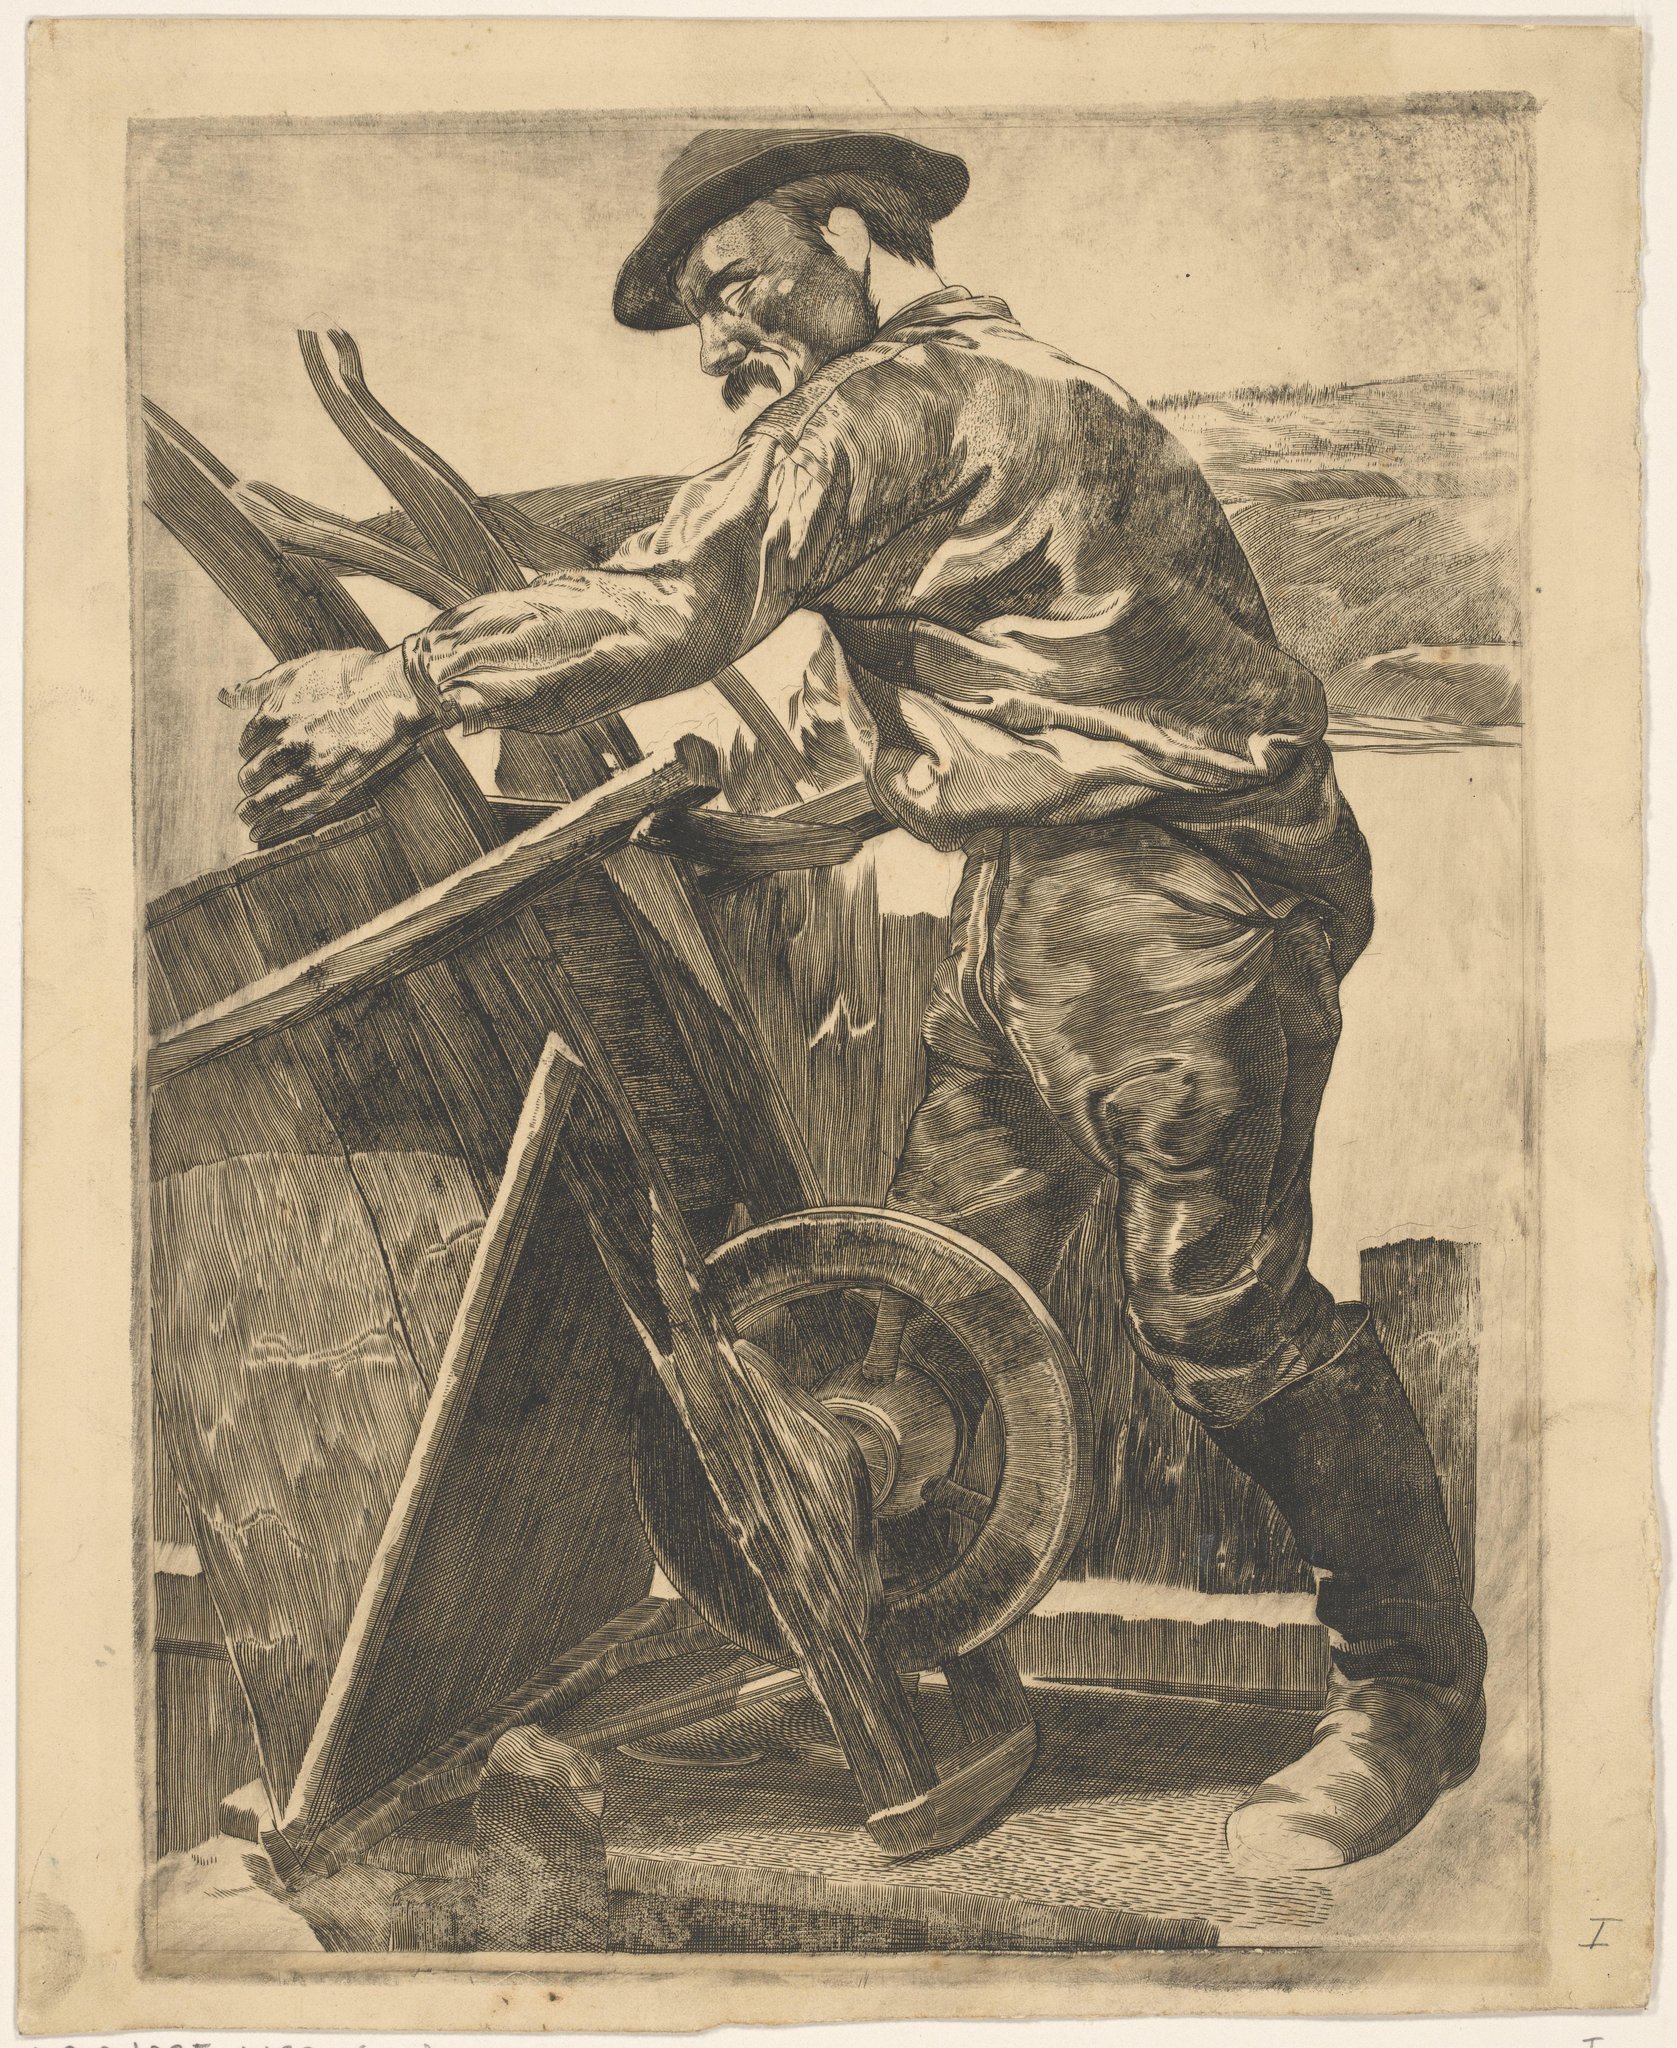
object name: print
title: Arbeider met een kruiwagen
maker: johannes josephus aarts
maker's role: draughtsman, print maker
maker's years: 1871-1934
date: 1881-1934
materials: paper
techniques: engraving, intaglio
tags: working class, labourers, wheelbarrow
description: Een man met hoed keert een houten kruiwagen om. Op de achtergrond water en heuvels.